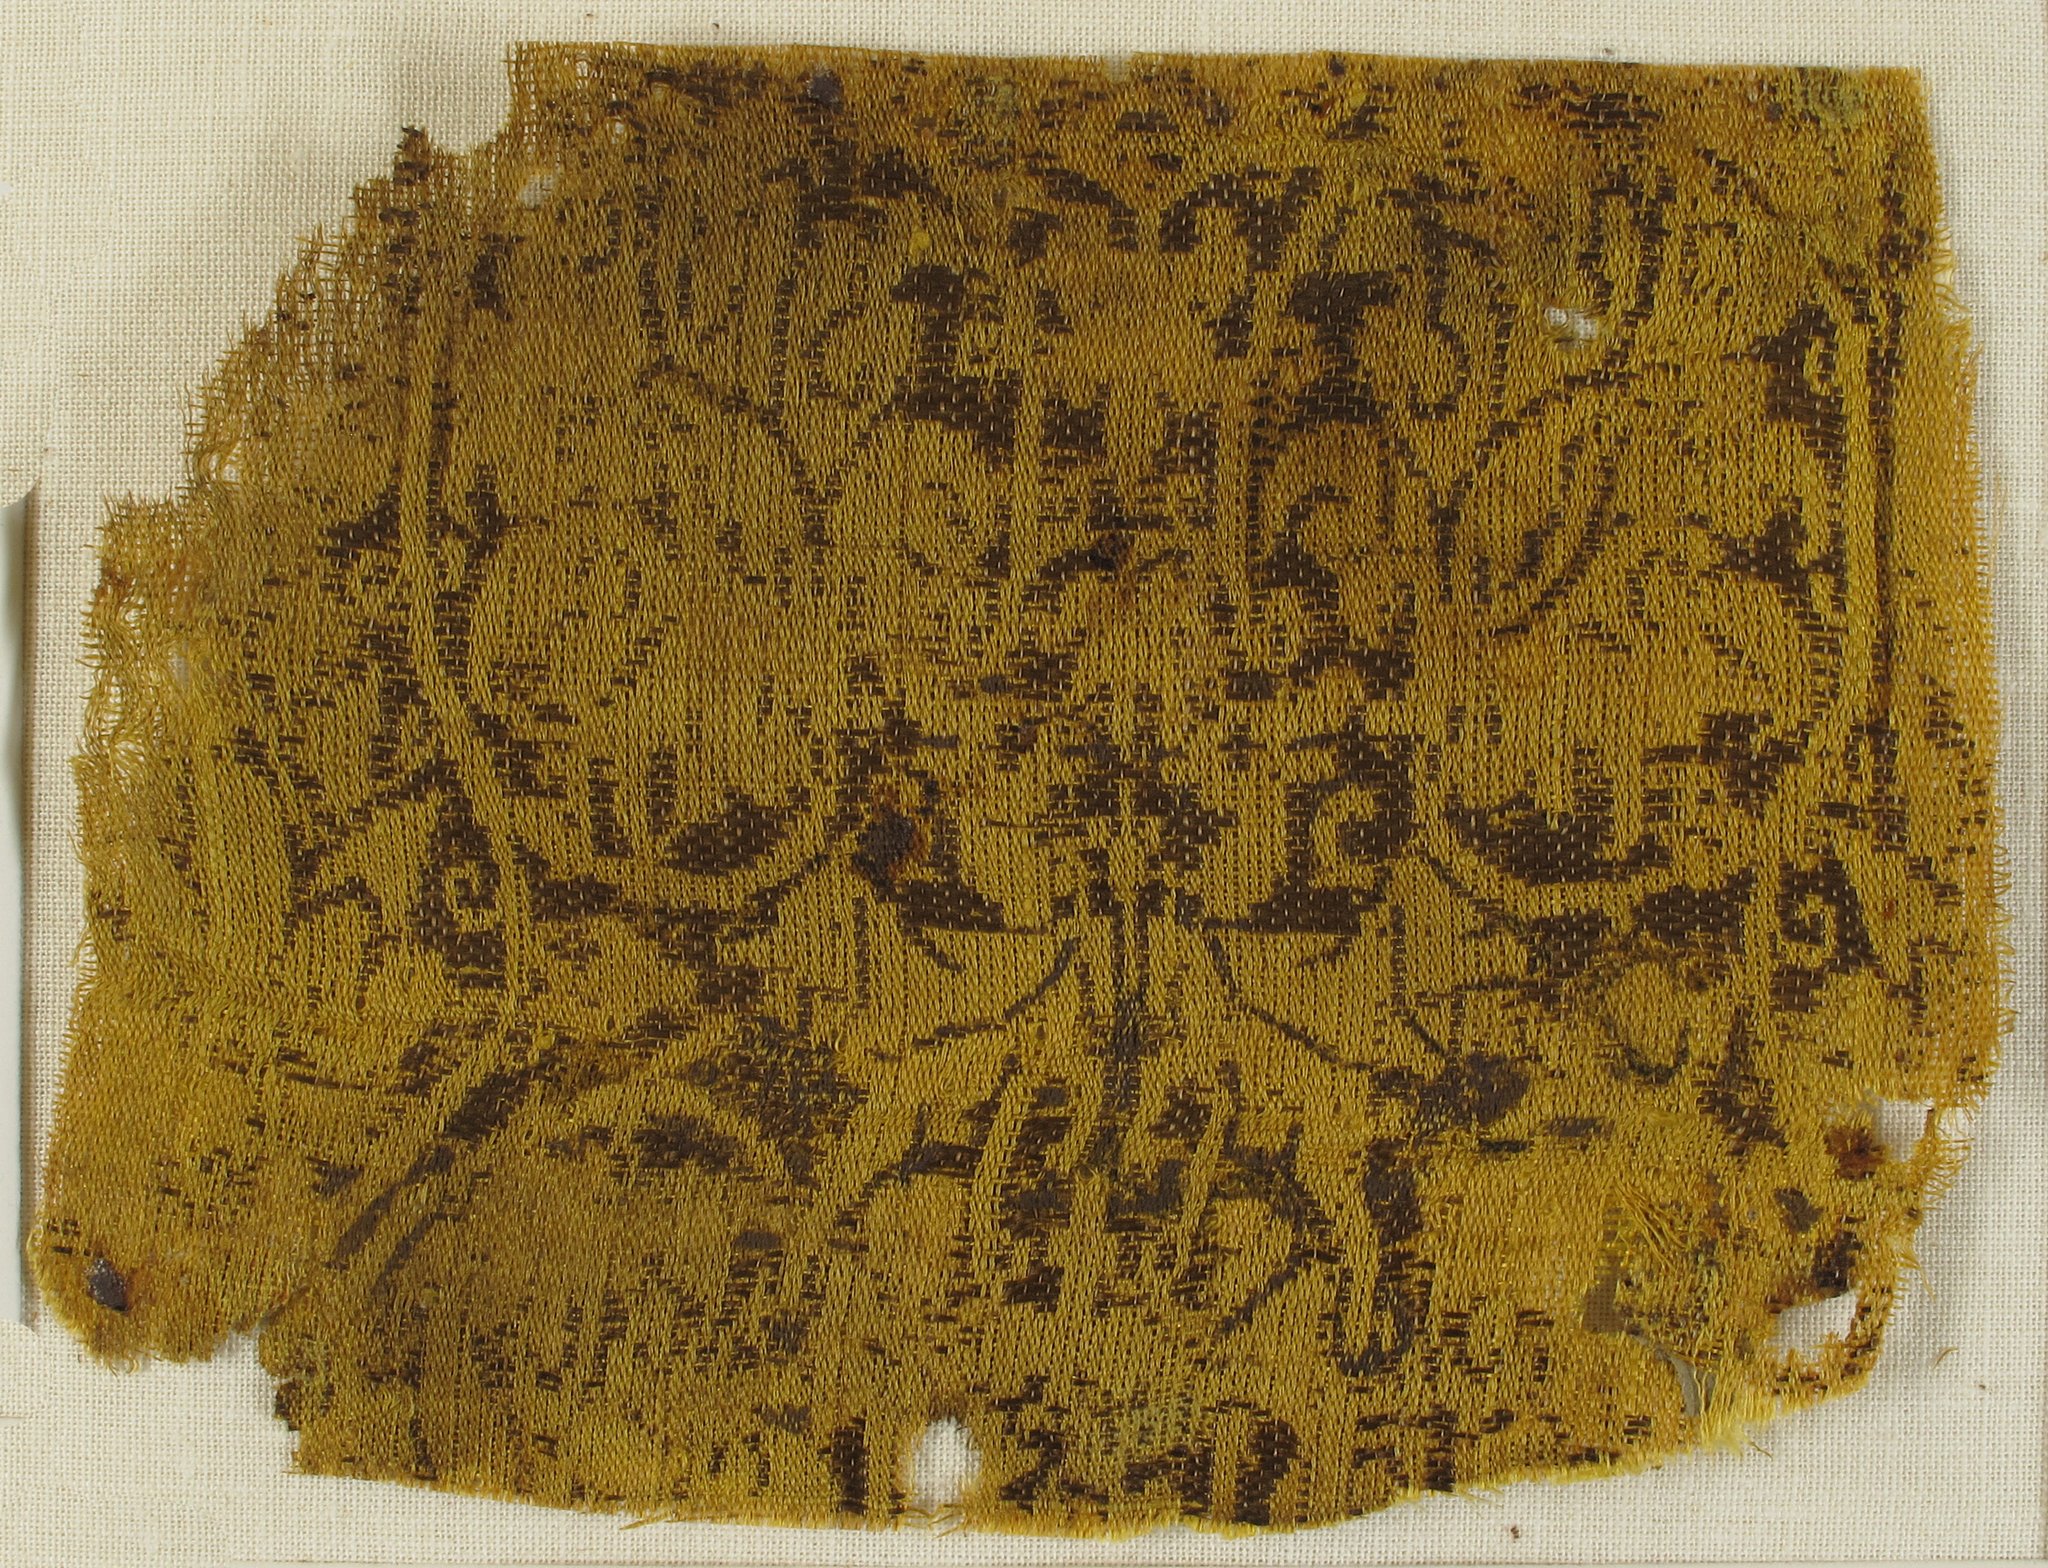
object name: textile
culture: italian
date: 1301-1400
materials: silk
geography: italy